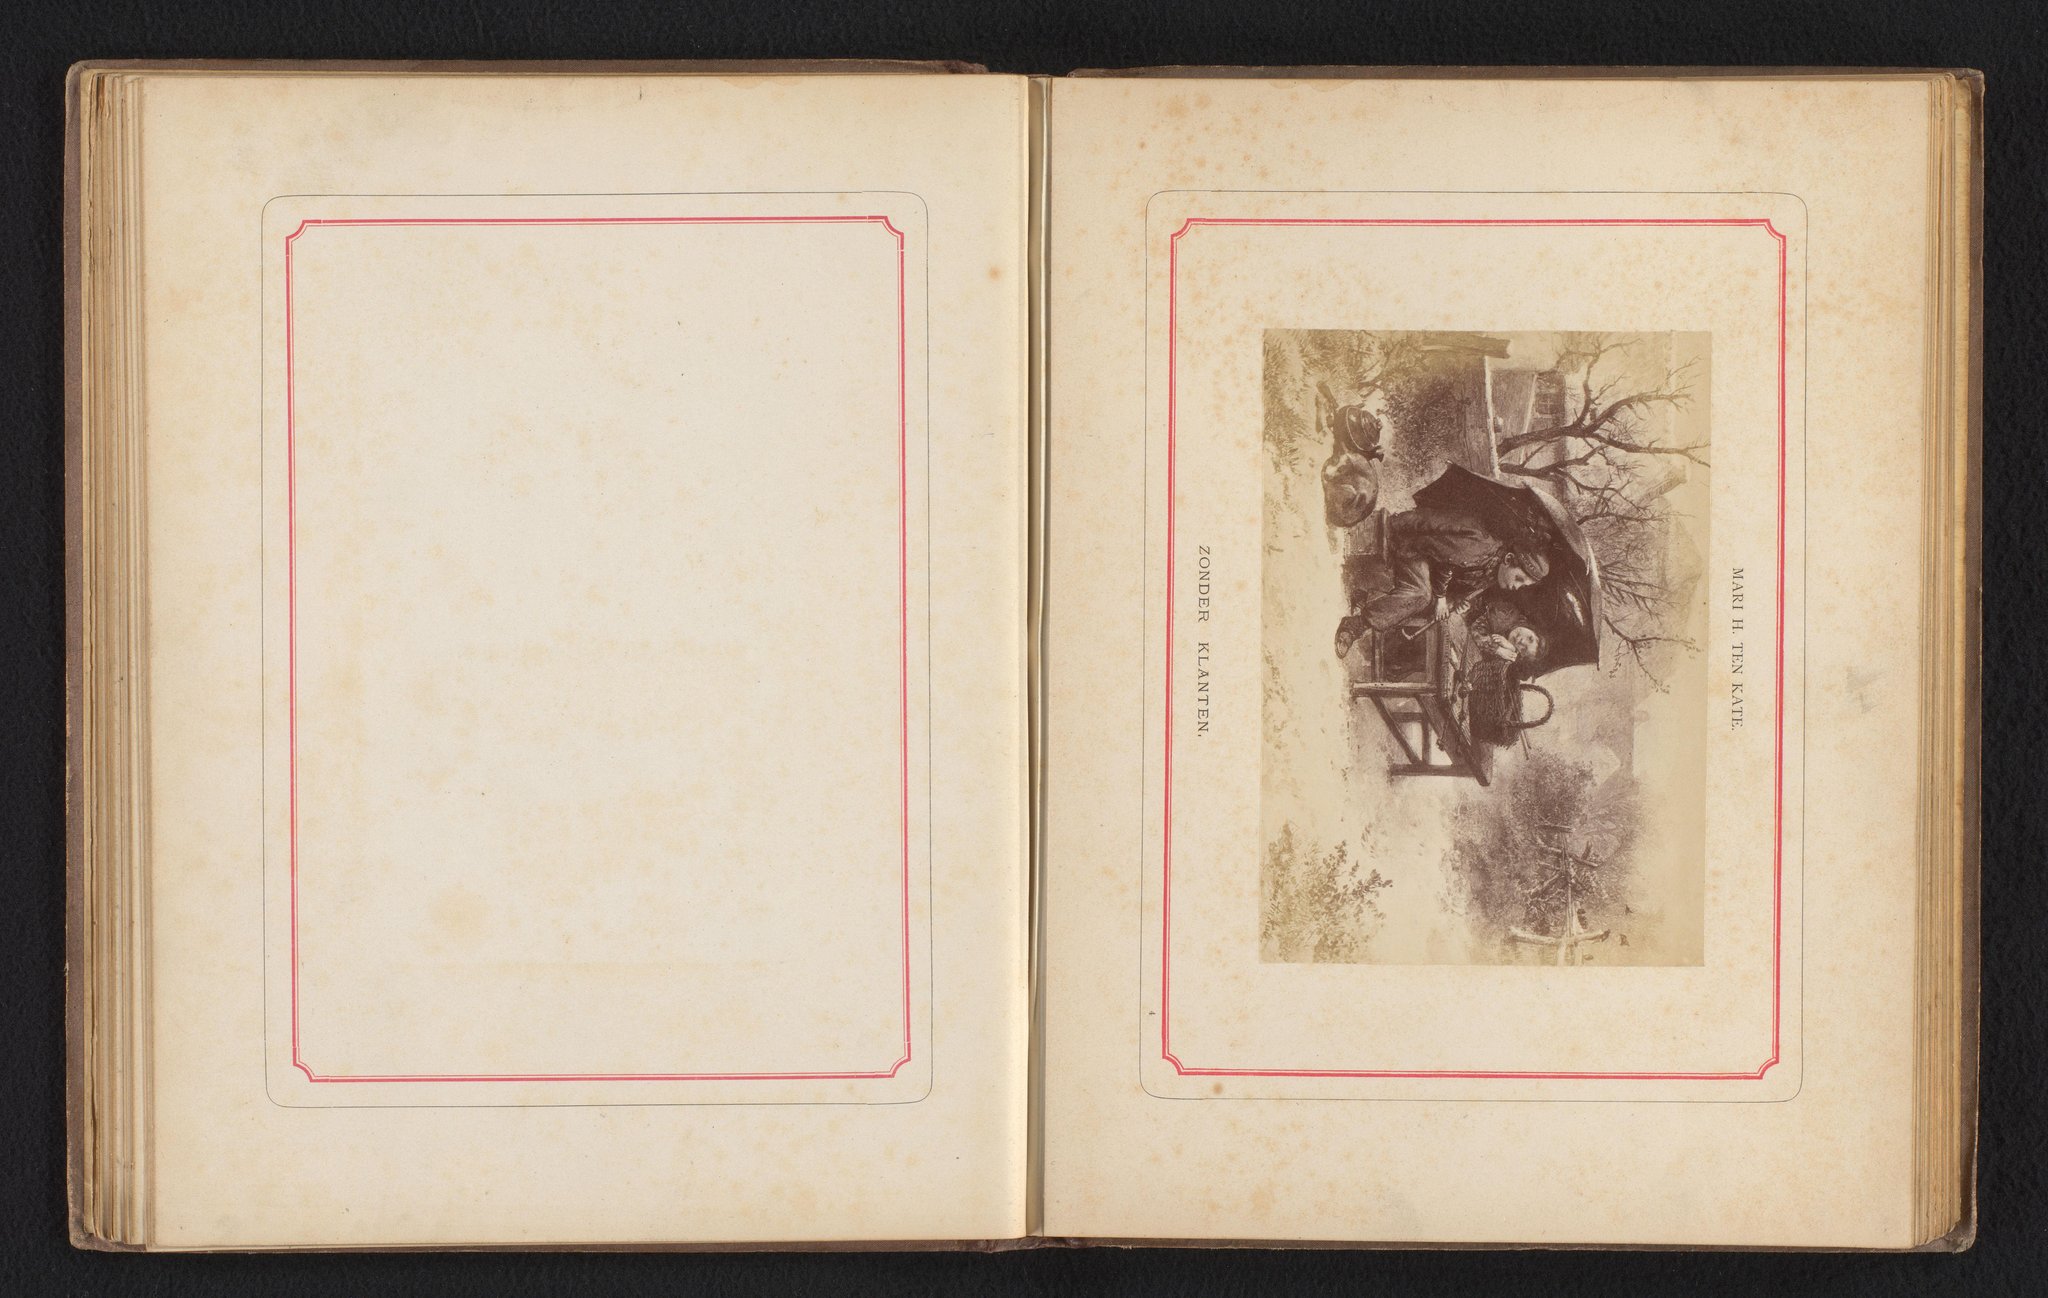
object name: photograph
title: Fotoreproductie van het schilderij 'Zonder klanten' door Mari ten Kate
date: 1865-1878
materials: paper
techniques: albumen print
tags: children's games and plays